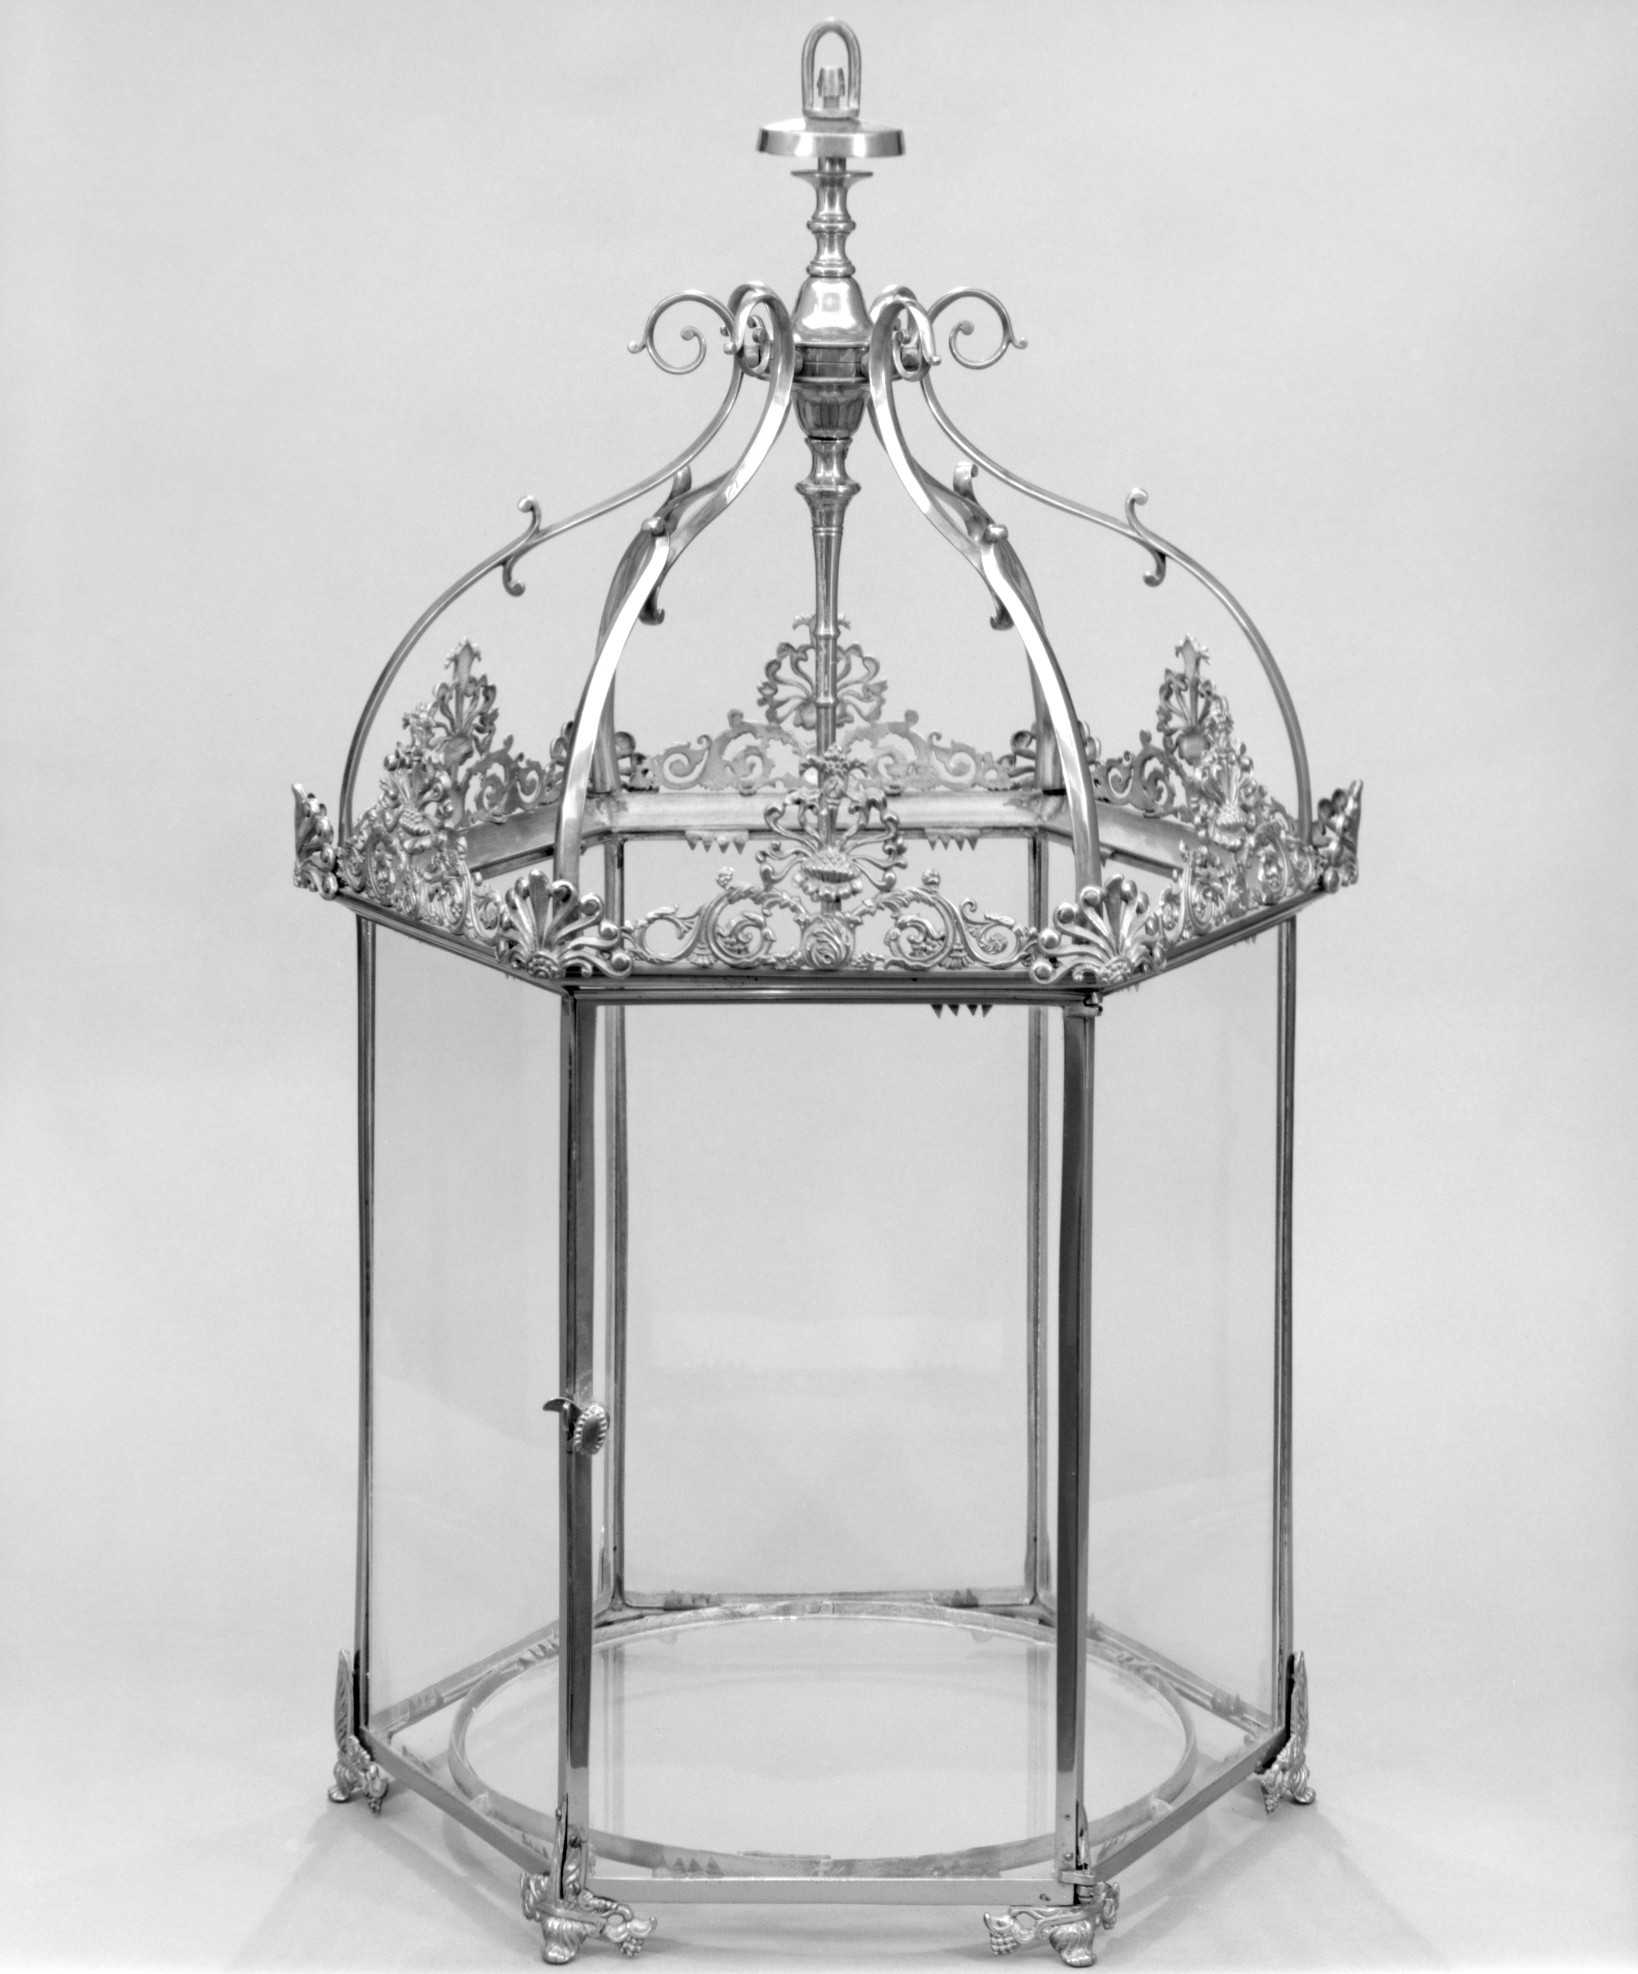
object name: lantern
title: Hanging lantern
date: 1767-1833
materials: brass, gilt bronze, glass